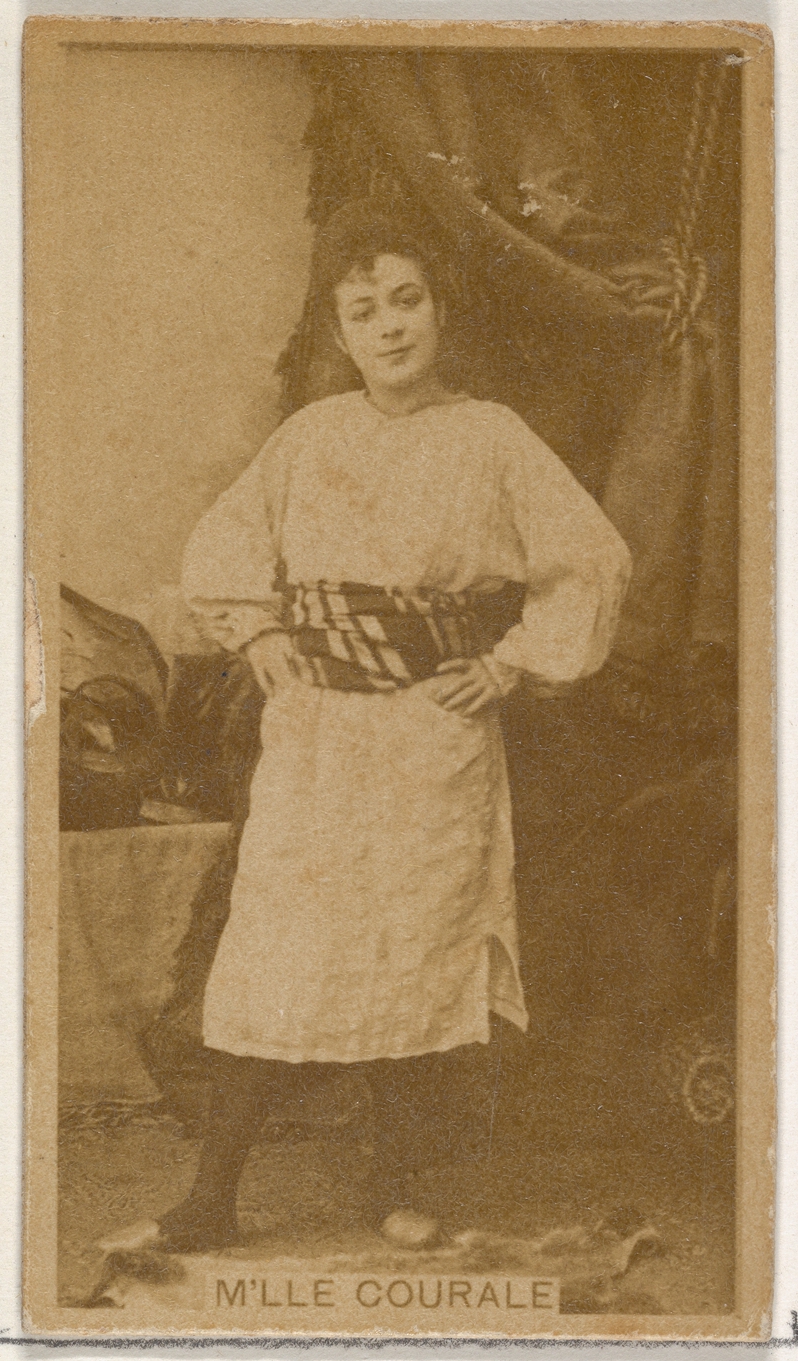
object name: photograph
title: M'lle Couralet, from the Actors and Actresses series (N45, Type 8) for Virginia Brights Cigarettes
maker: allen & ginter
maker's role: publisher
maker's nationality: american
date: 1888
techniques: albumen silver print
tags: portraits,women,actresses